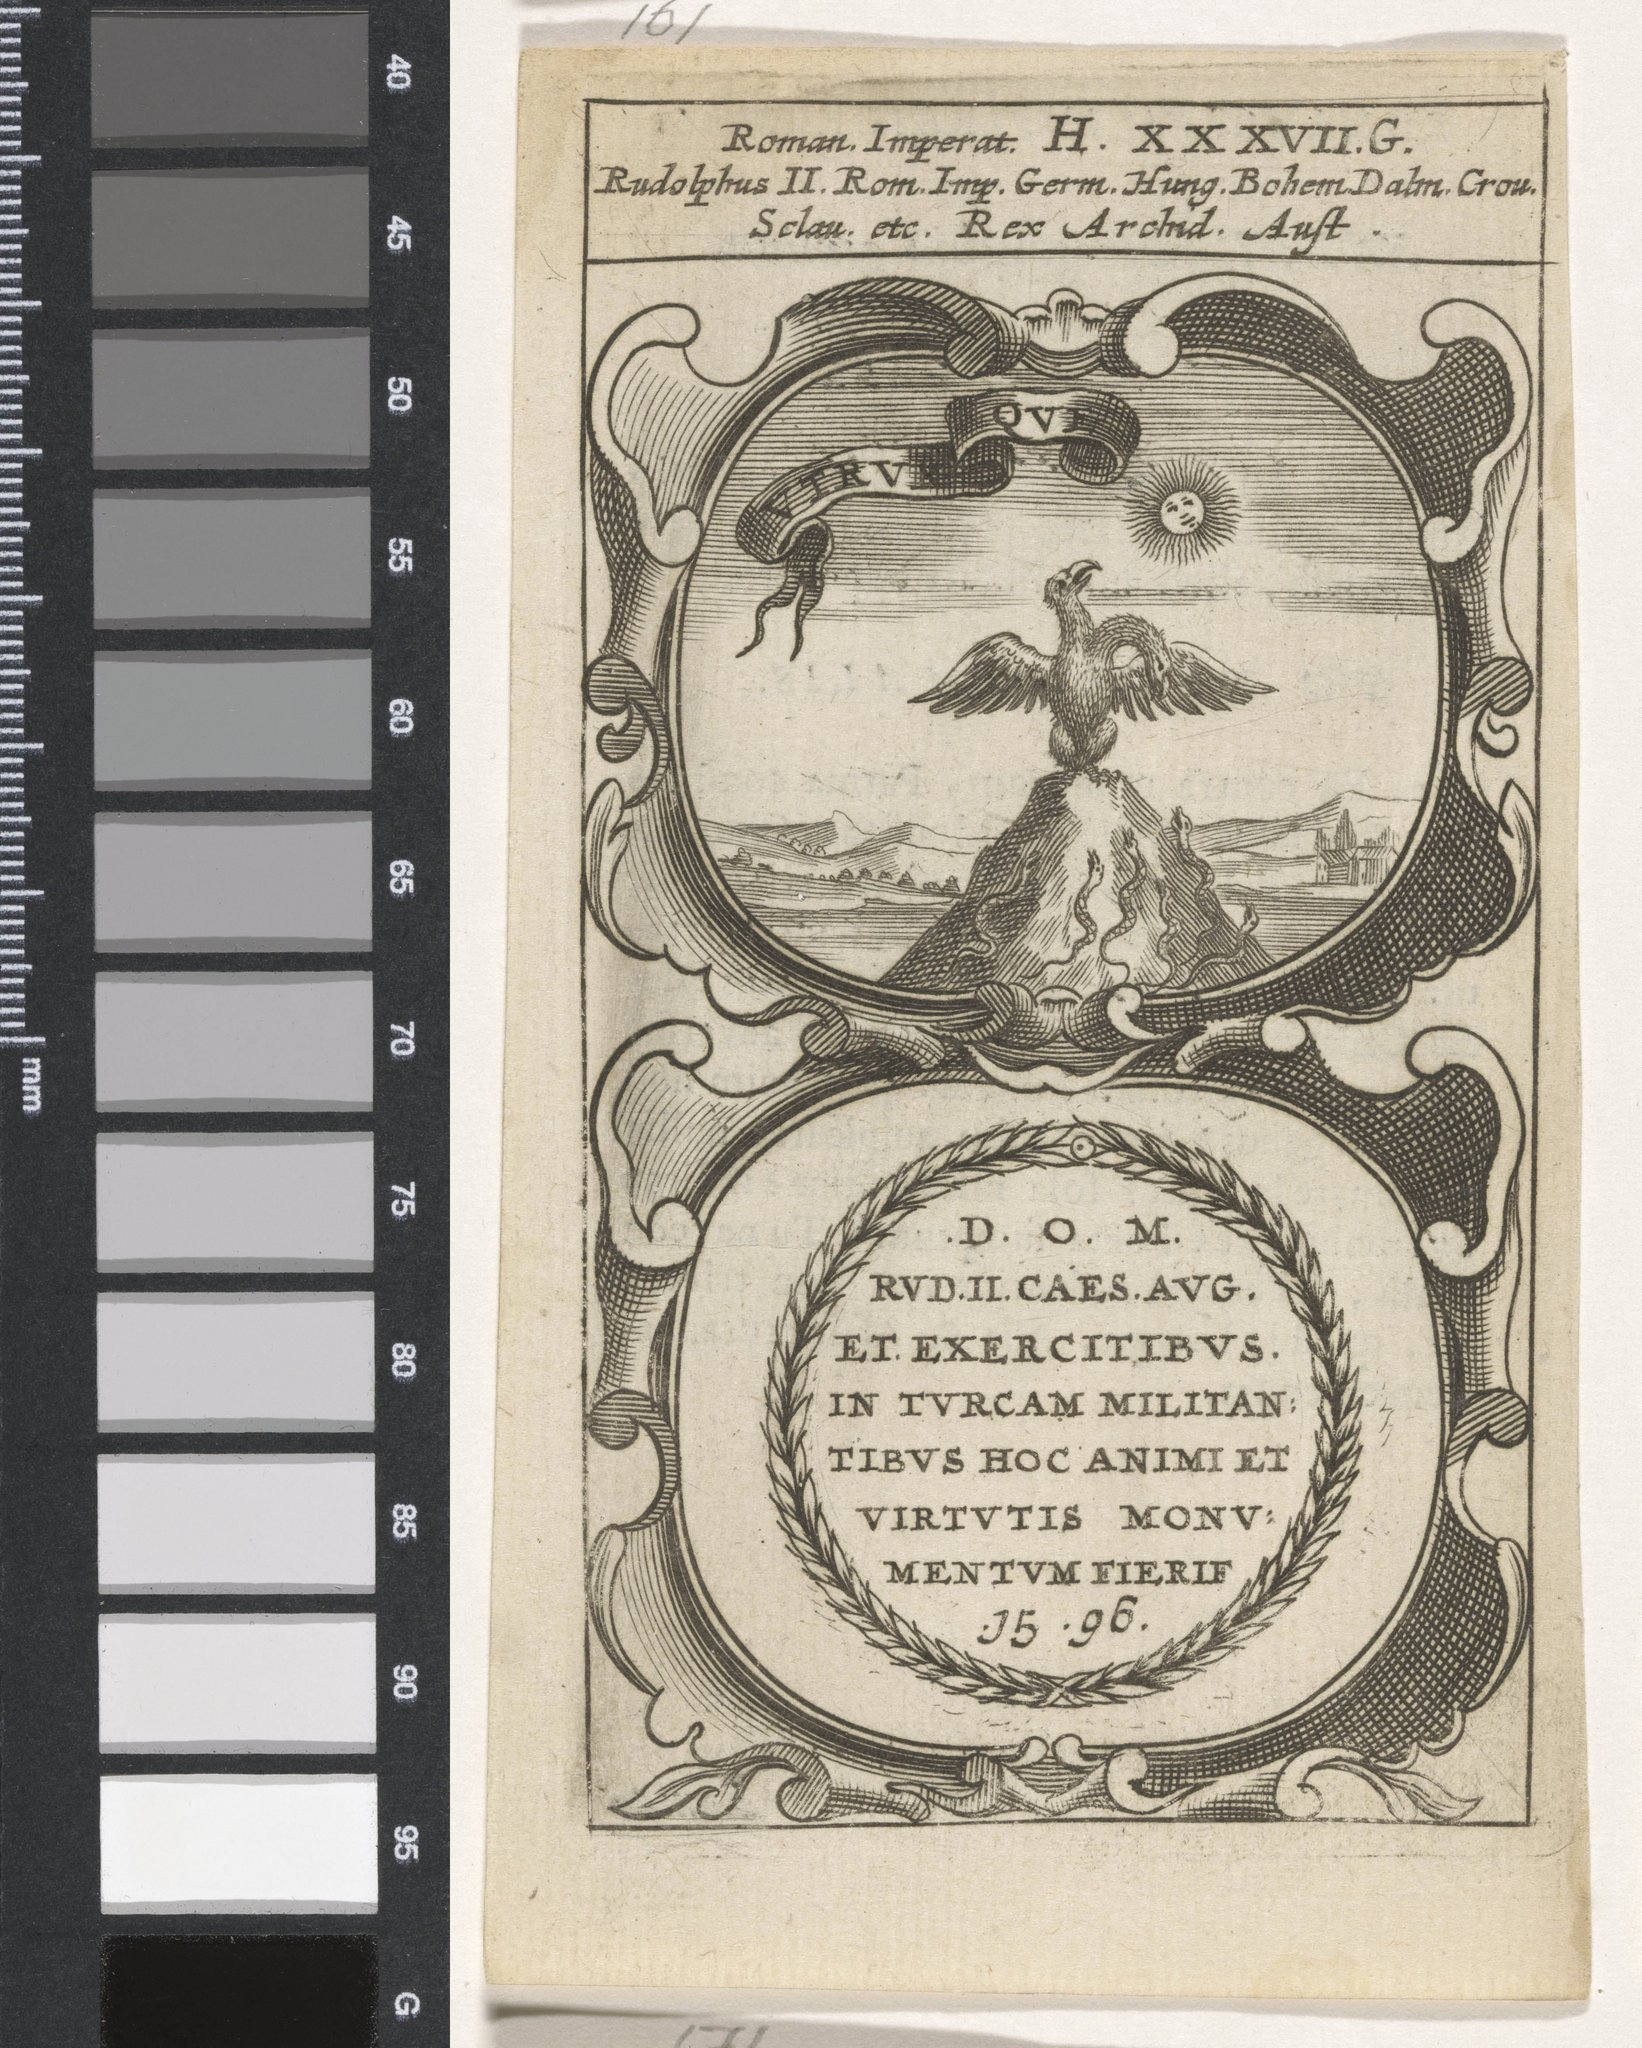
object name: print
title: Symbola Divina et Humana Pontificum Imperatorum Regum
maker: Anonymous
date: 1666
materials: paper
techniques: engraving, letterpress printing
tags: prague, rudolf ii van habsburg (duits keizer), double-headed eagle, garland, wreath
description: Pagina uit Jacob Typotius, Symbola Divina & Humana Pontificum Imperatorum Regum. Arnhem, J.F. Hagen, 1666 of uit de titeluitgave van 1669 of 1679. Het werk van Typotius werd voor het eerst uitgegeven in 1601 met prenten van Aegidius Sadeler.